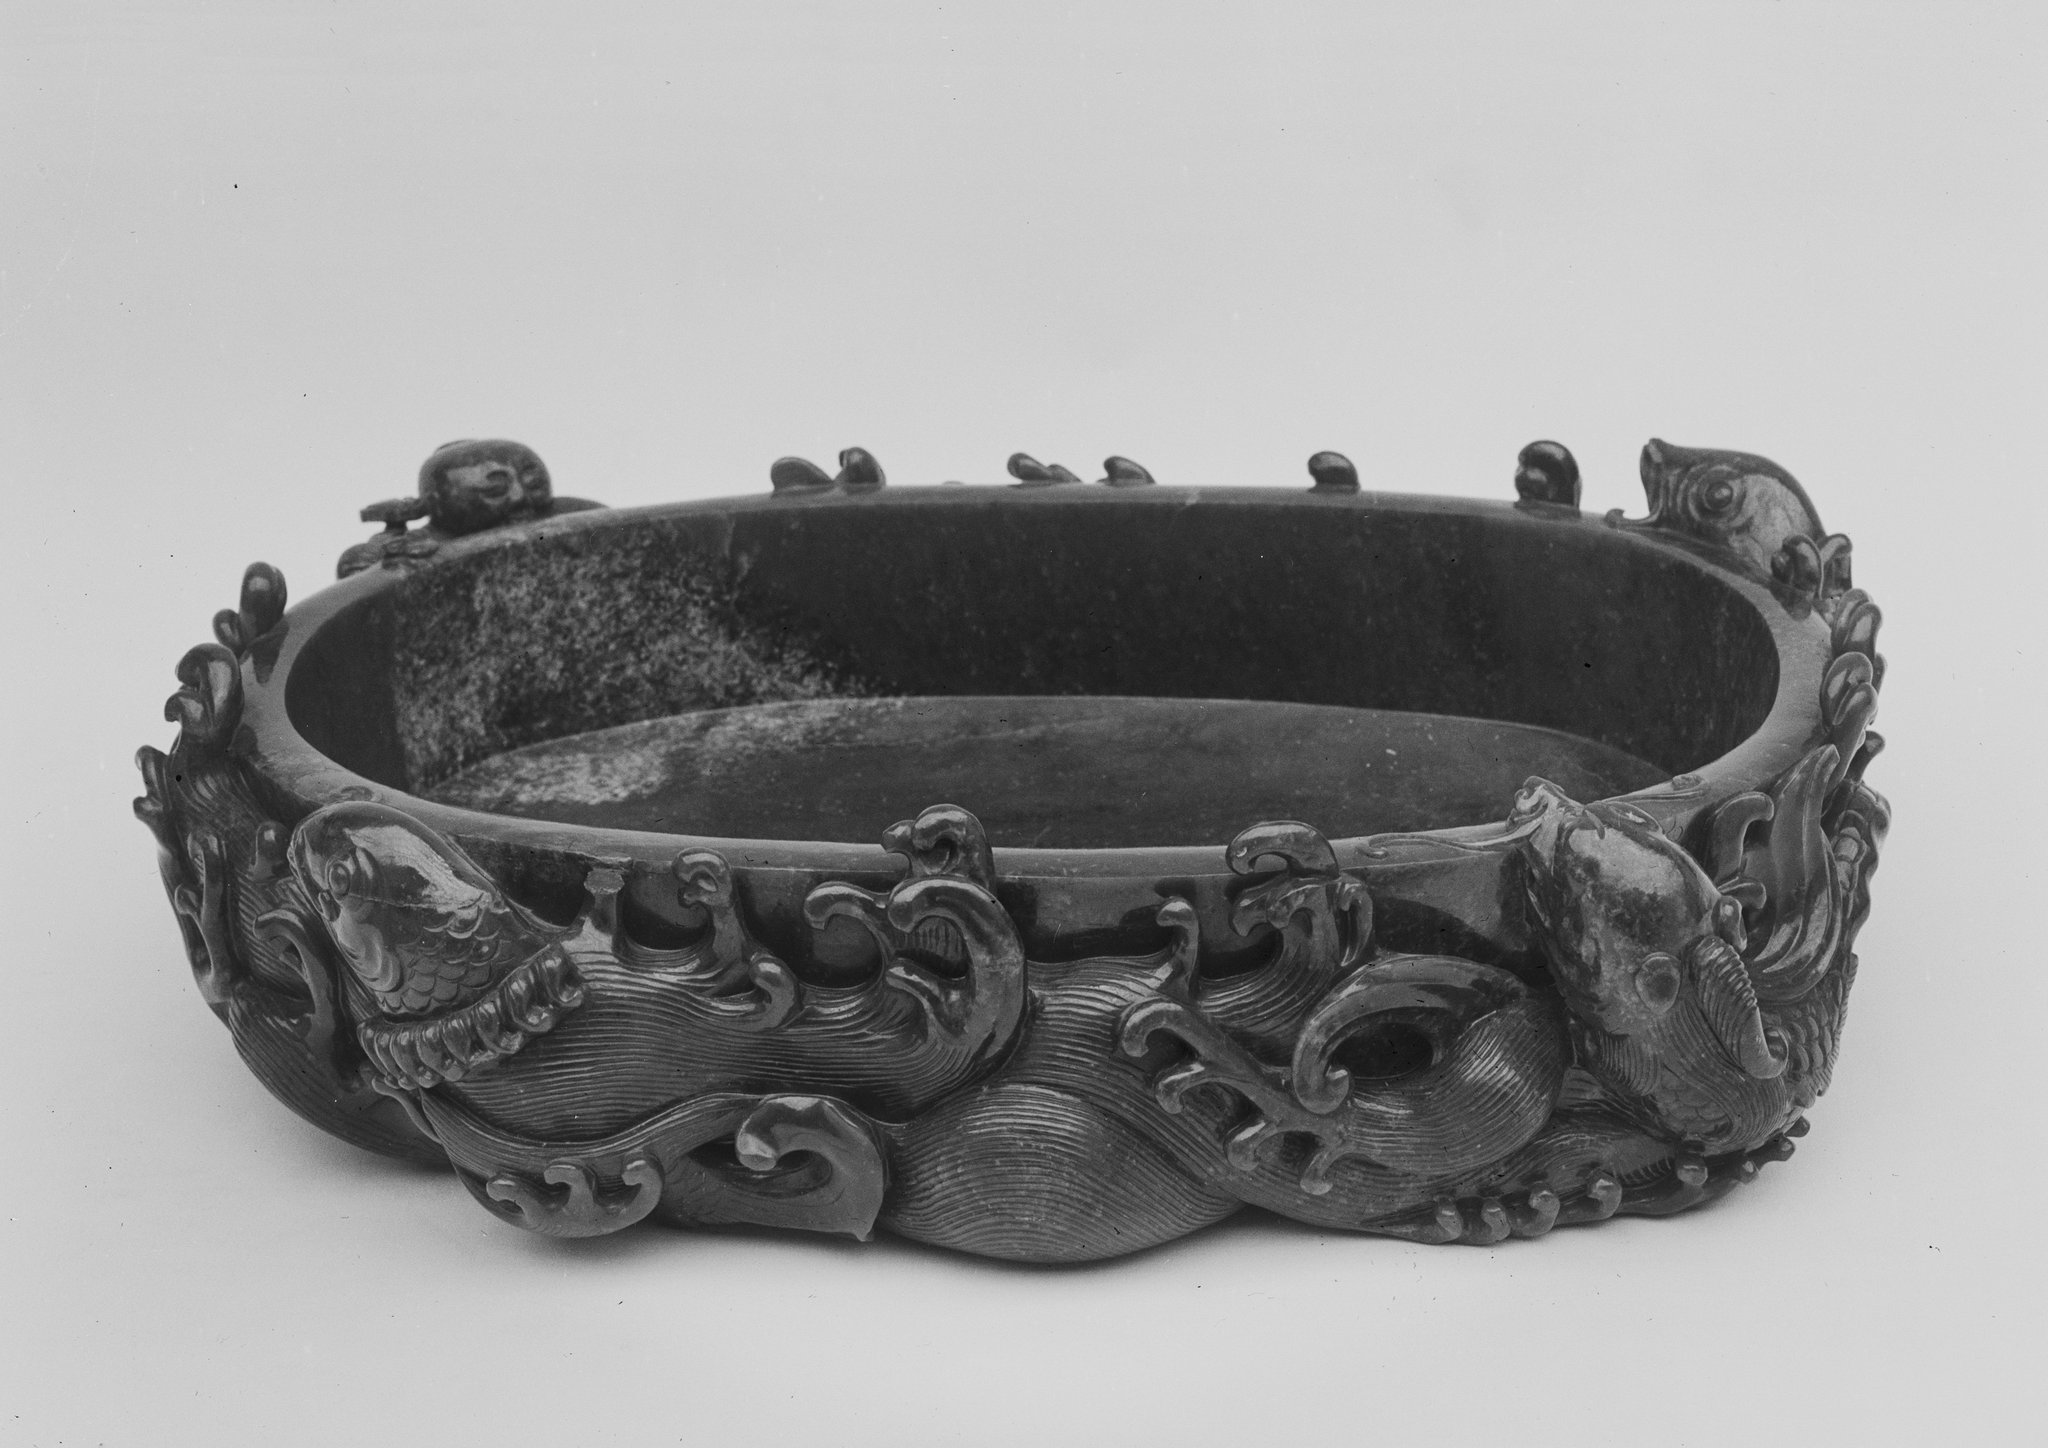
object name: basin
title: Oval Basin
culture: chinese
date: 1736-1795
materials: jade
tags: fish